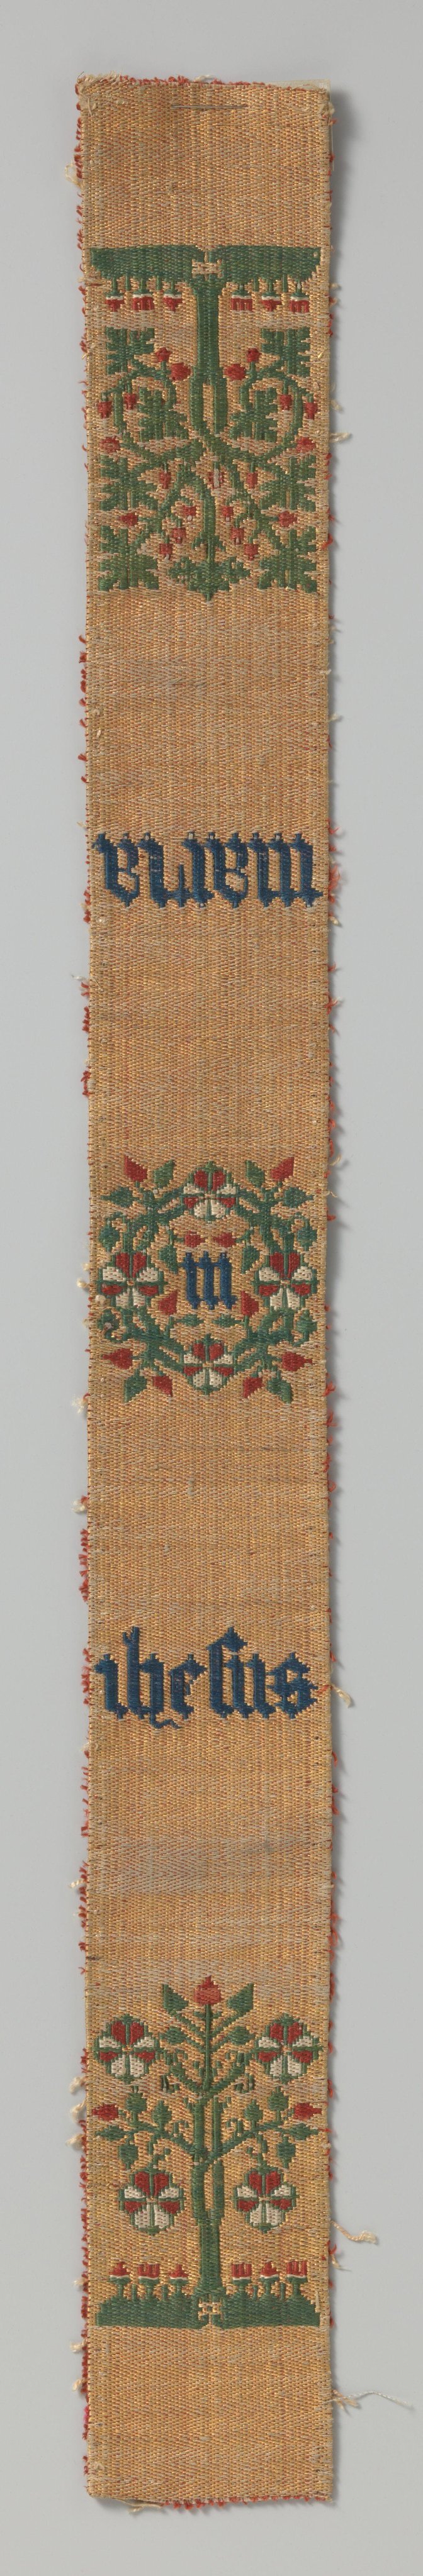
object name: band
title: Rand, fragment, geweven, met bebloemde bomen afwisselend met een rozet en de woorden 'ihesis maria'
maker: Anonymous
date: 1499-1700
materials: textile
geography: cologne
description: Rand, geweven, met bebloemde bomen, afwisselend met een rozet en de woorden 'ihesis maria', in wit blauw, groen en rood op gouden ondergrond. Keuls werk.